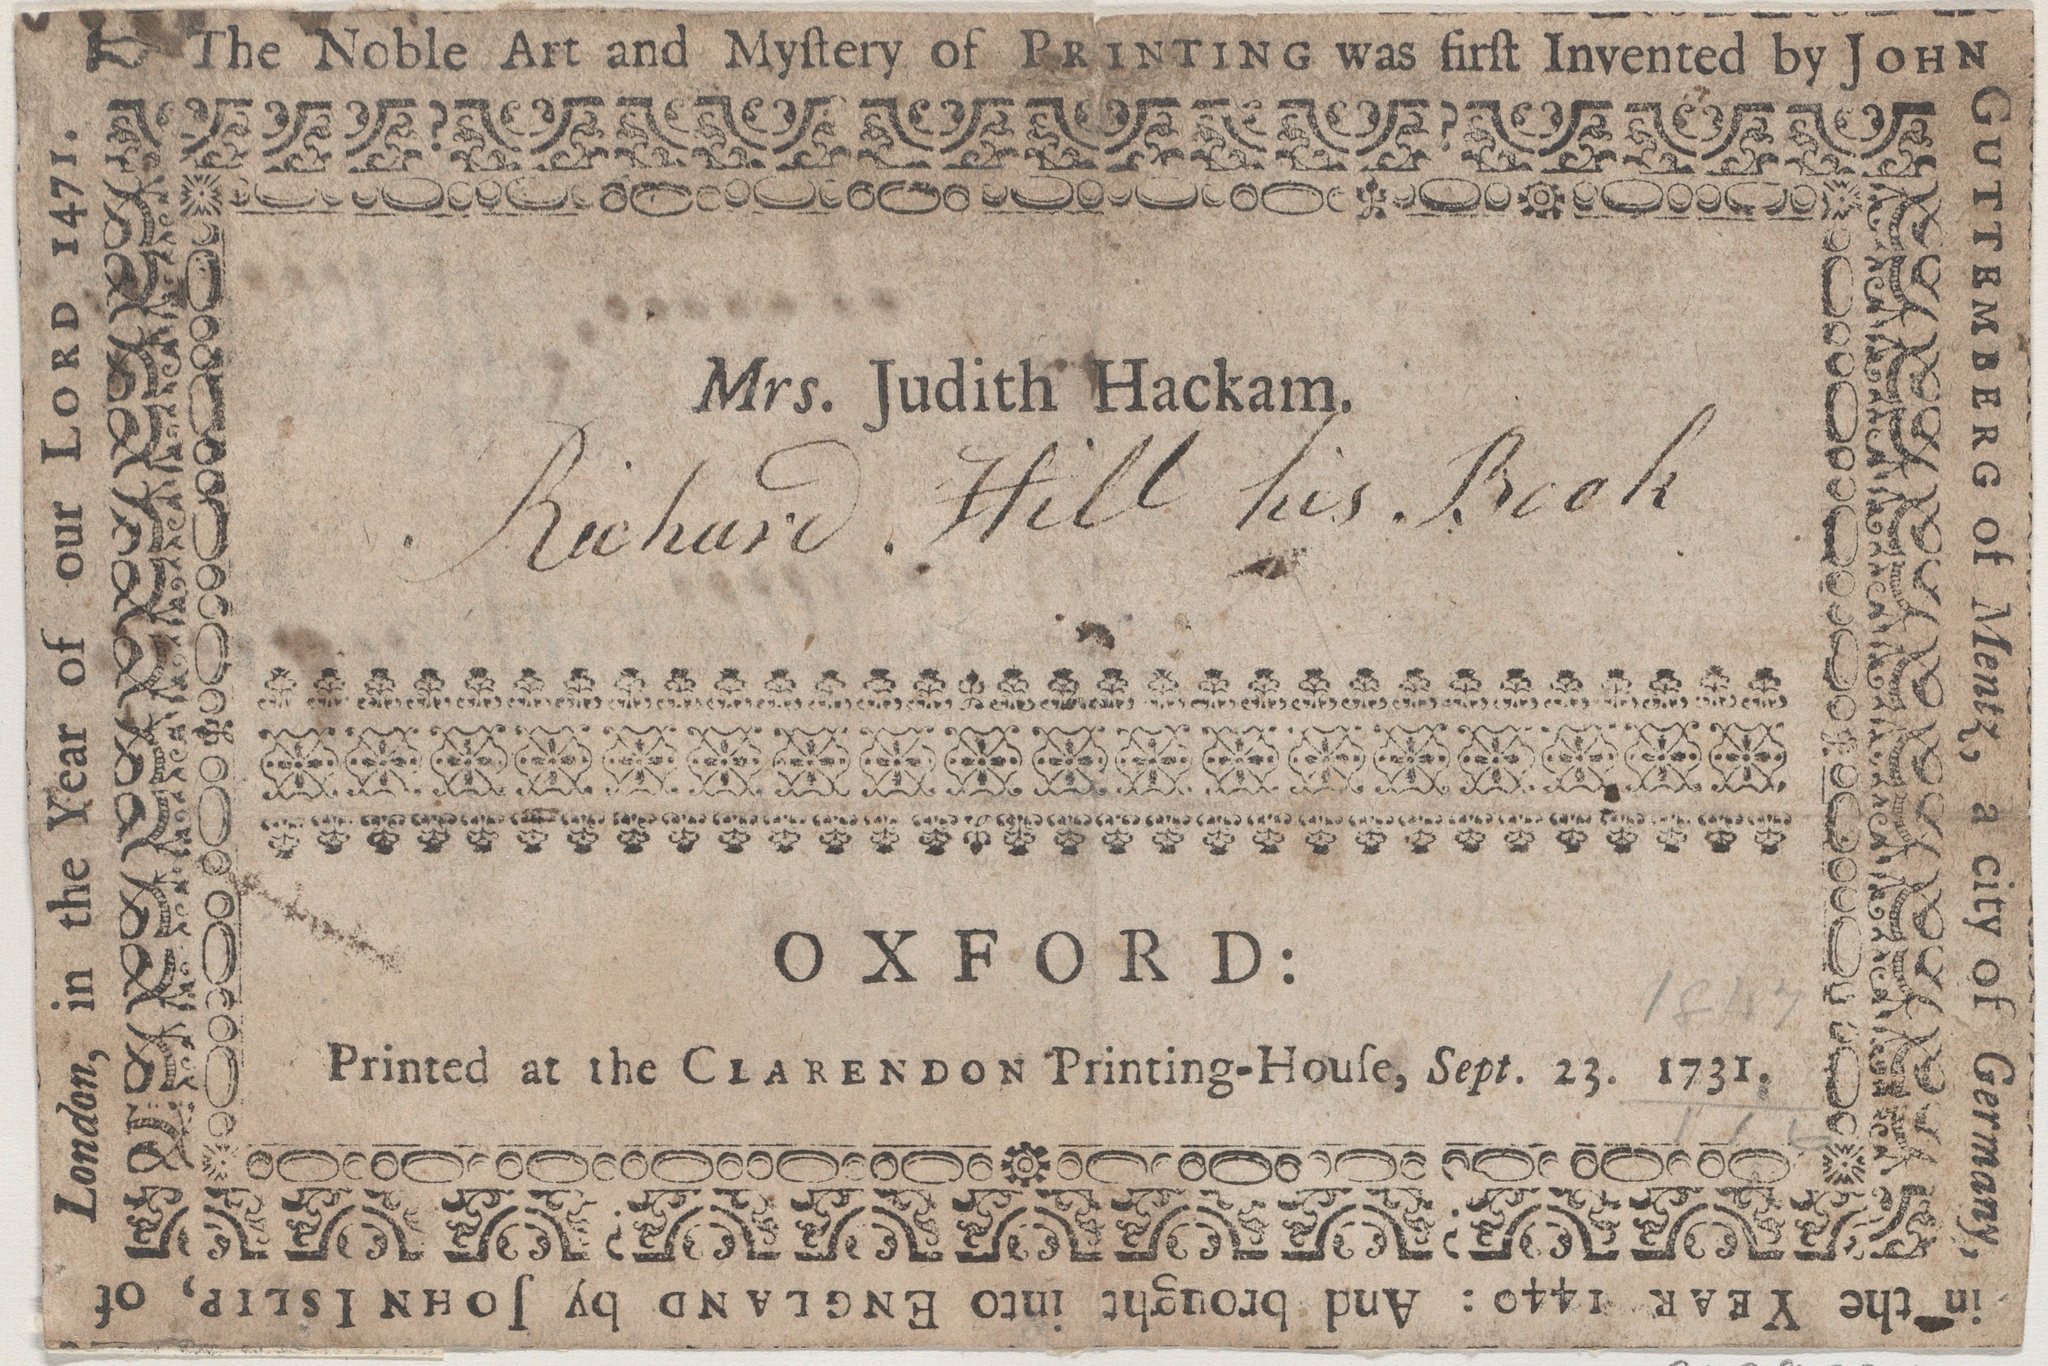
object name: print, trade card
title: Book Label for Mrs. Judith Hackam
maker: anonymous, british, 18th century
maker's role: artist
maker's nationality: british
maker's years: 1700-1800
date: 1801-1900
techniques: engraving